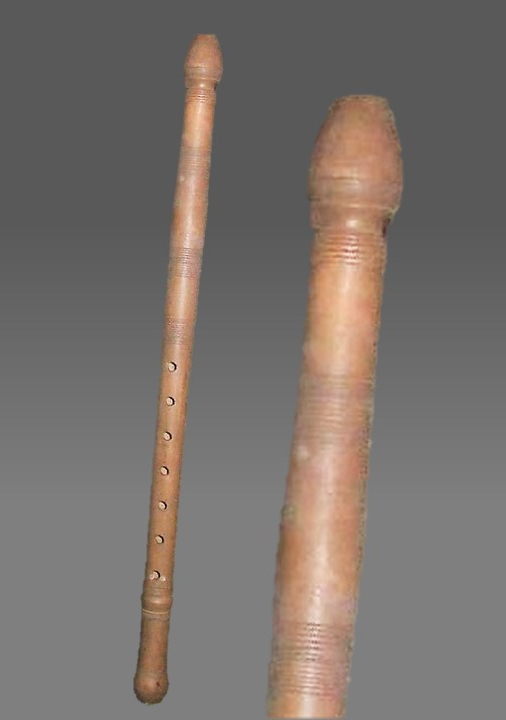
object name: kaval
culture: turkish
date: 1867-1900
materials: wood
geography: turkey